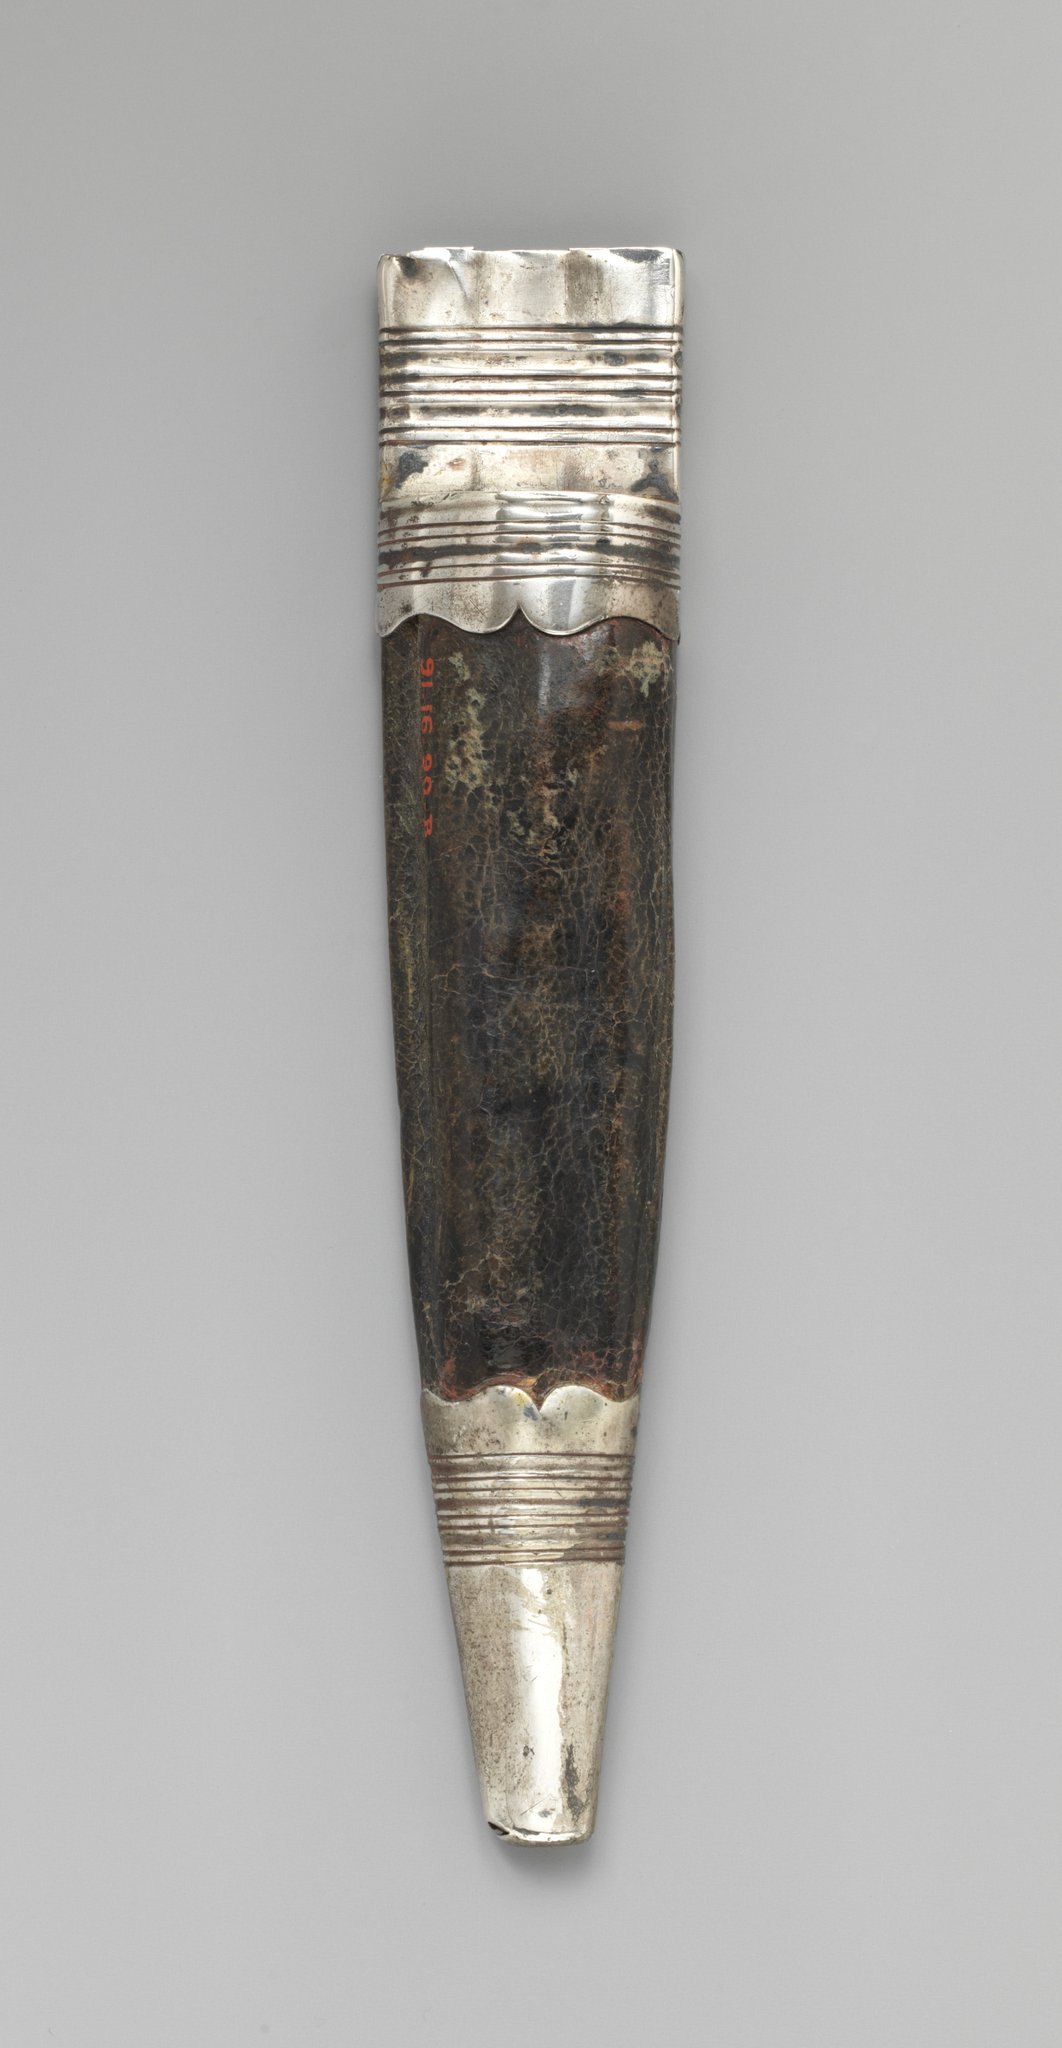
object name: knife with sheath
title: Sheath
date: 1767-1800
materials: leather, silver